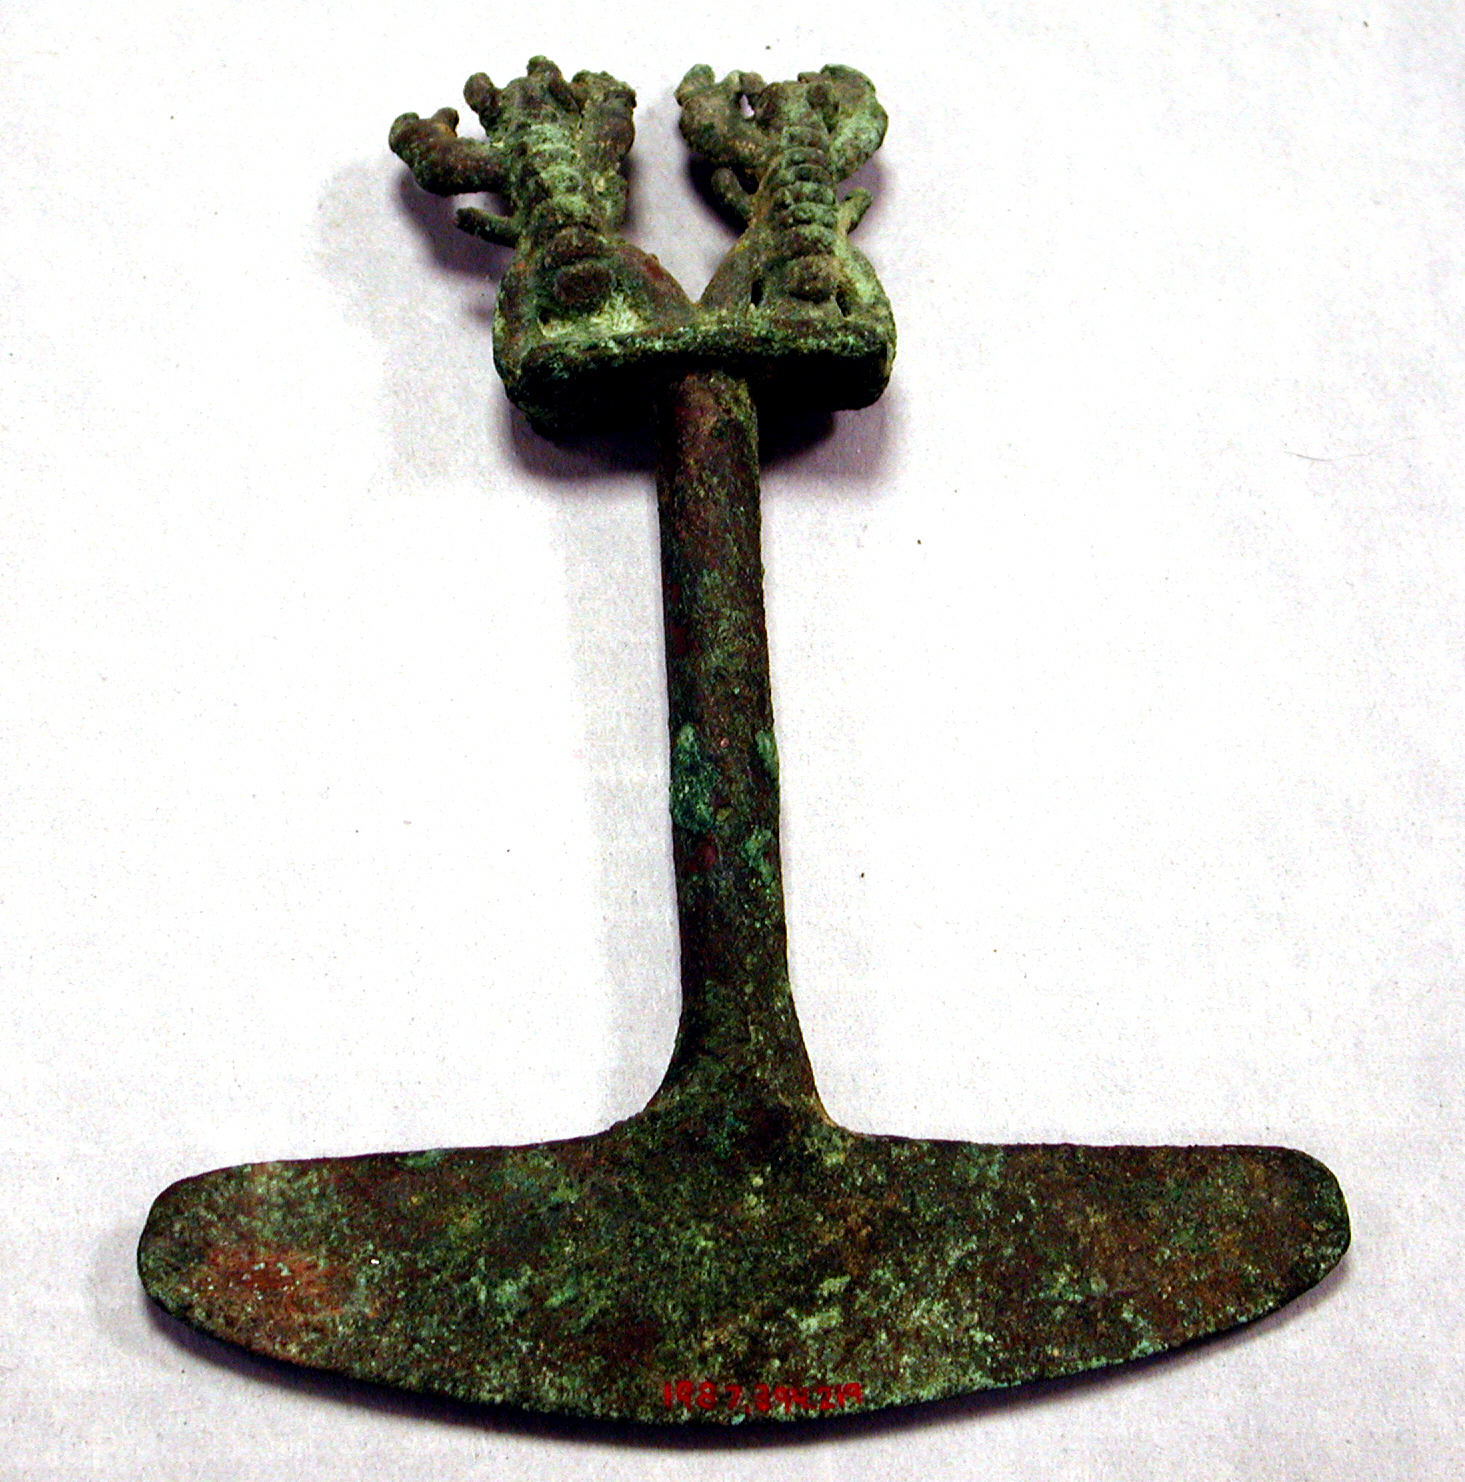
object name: knife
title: Ceremonial Knife (Tumi)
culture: chimú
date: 1101-1500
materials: copper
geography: peru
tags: animals